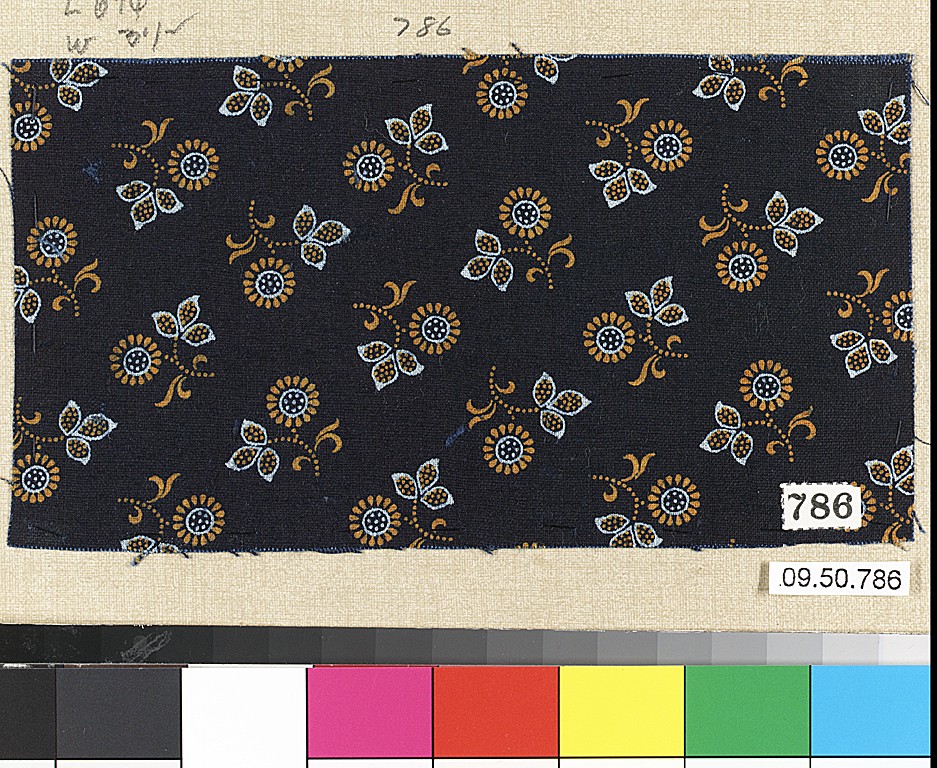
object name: piece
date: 1801-1900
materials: cotton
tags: flowers,leaves